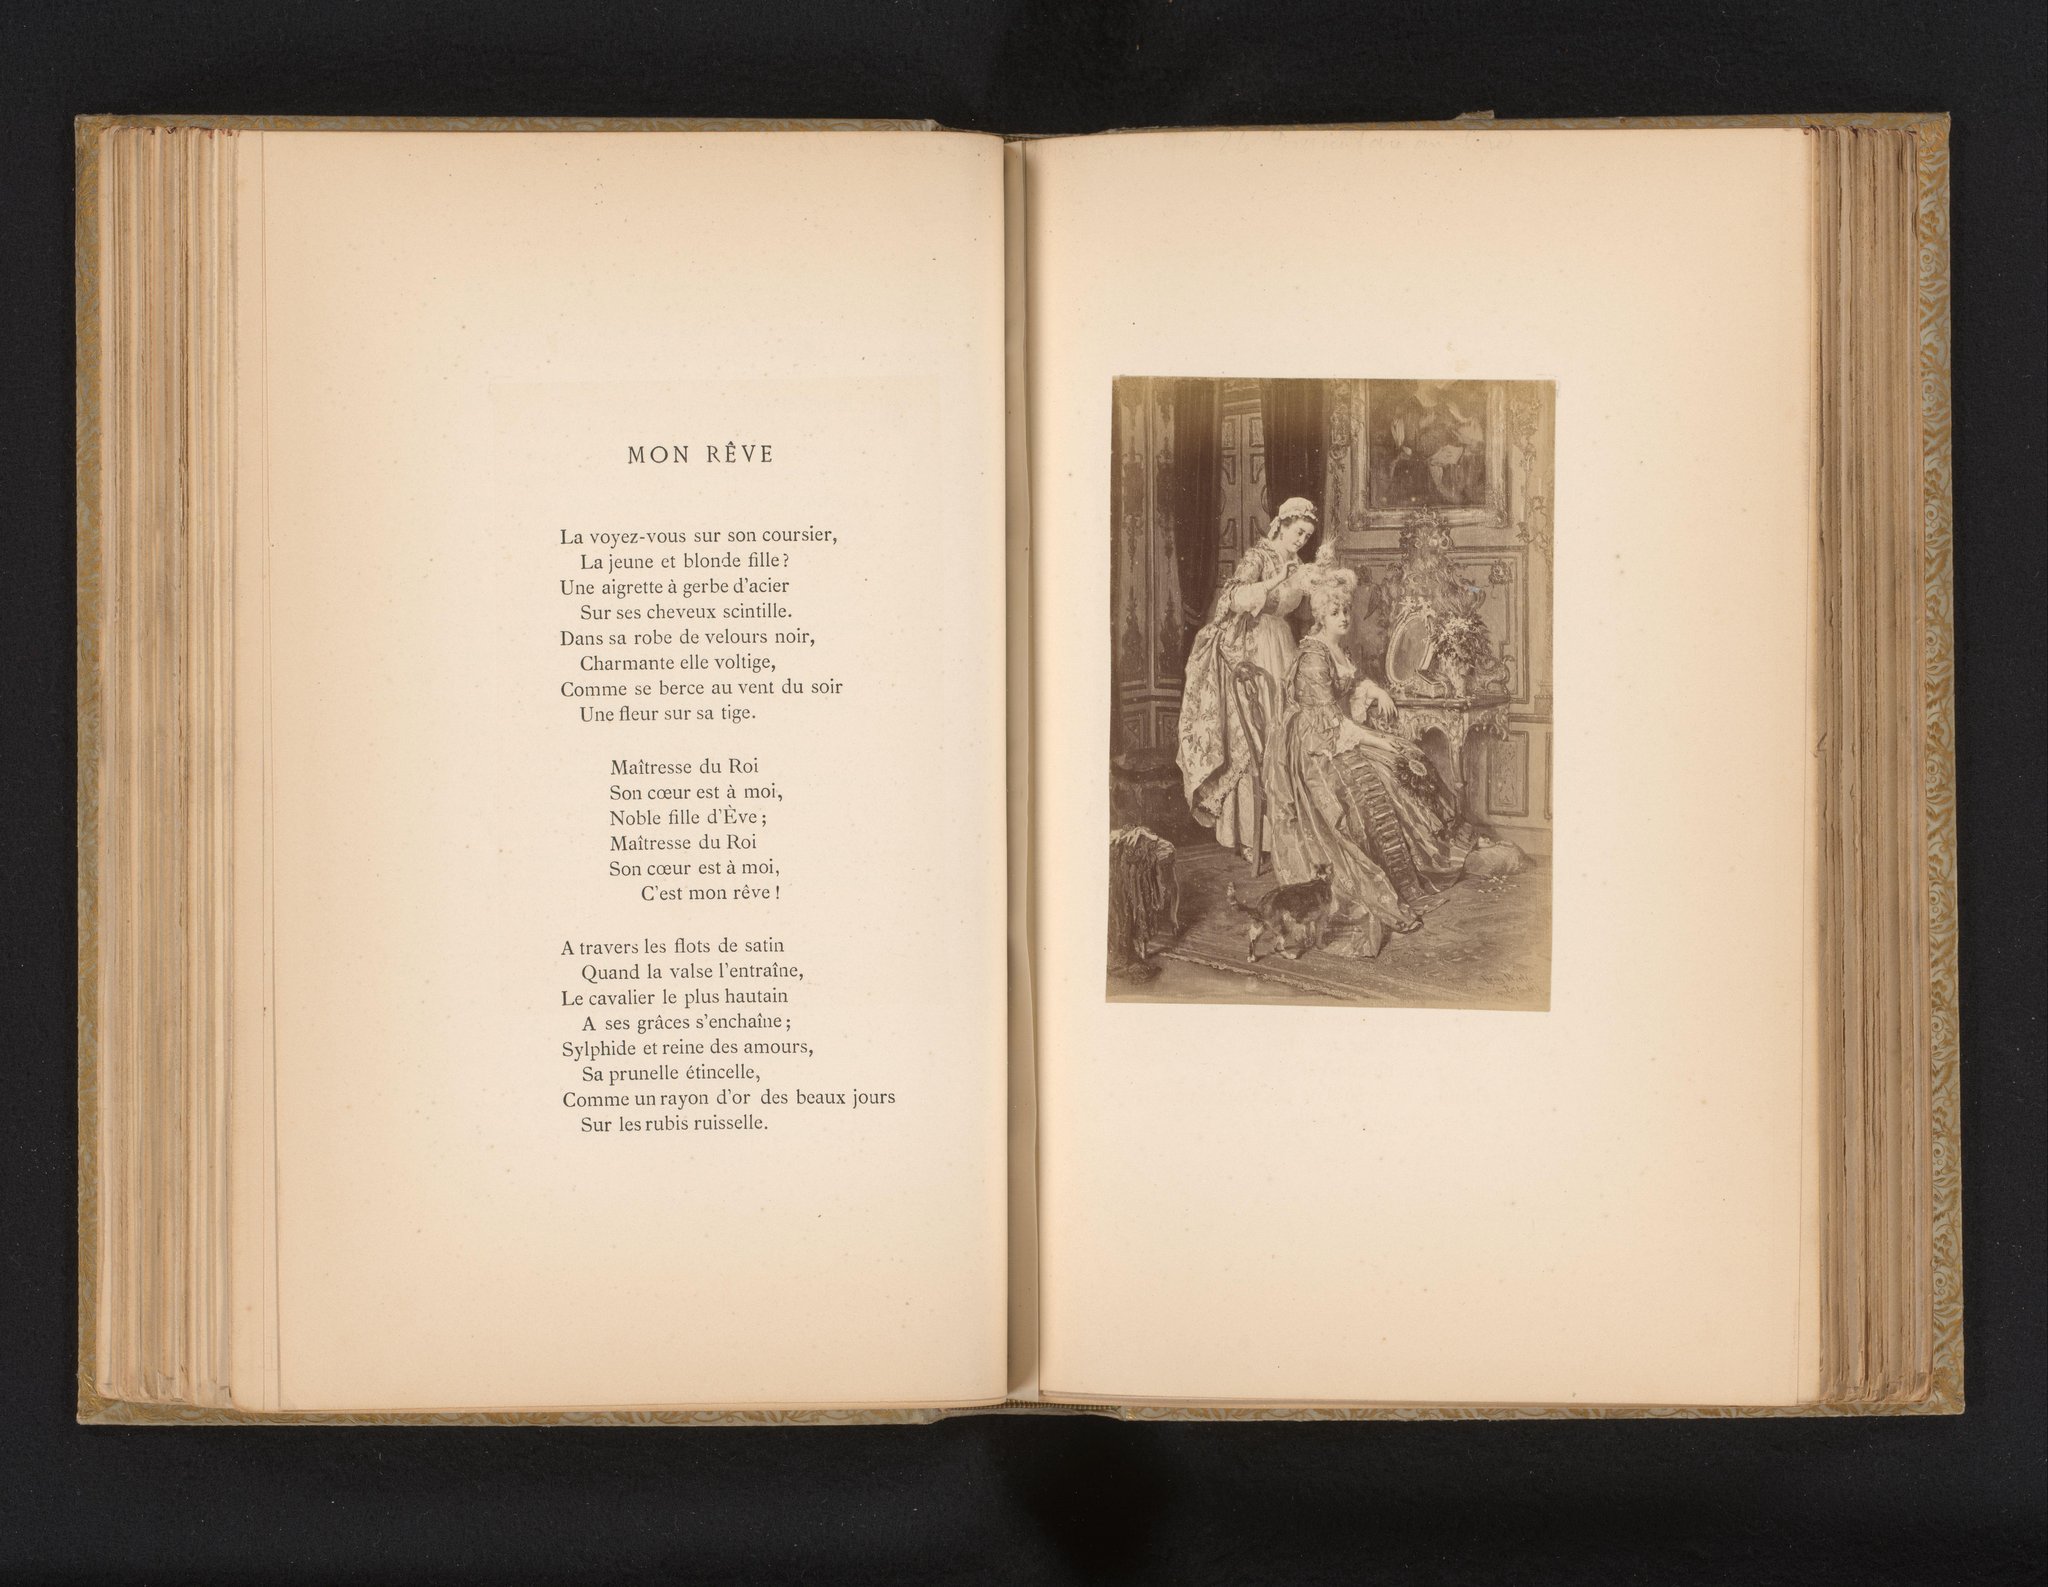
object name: reproduction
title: Fotoreproductie van een schilderij van een vrouw die gekapt wordt door Henry Mosler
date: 1874-1884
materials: paper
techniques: albumen print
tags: adult woman, wig - aa - ~ women, hairdresser, picture, painting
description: Foto op tweede ongenummerde pagina na pagina 85.